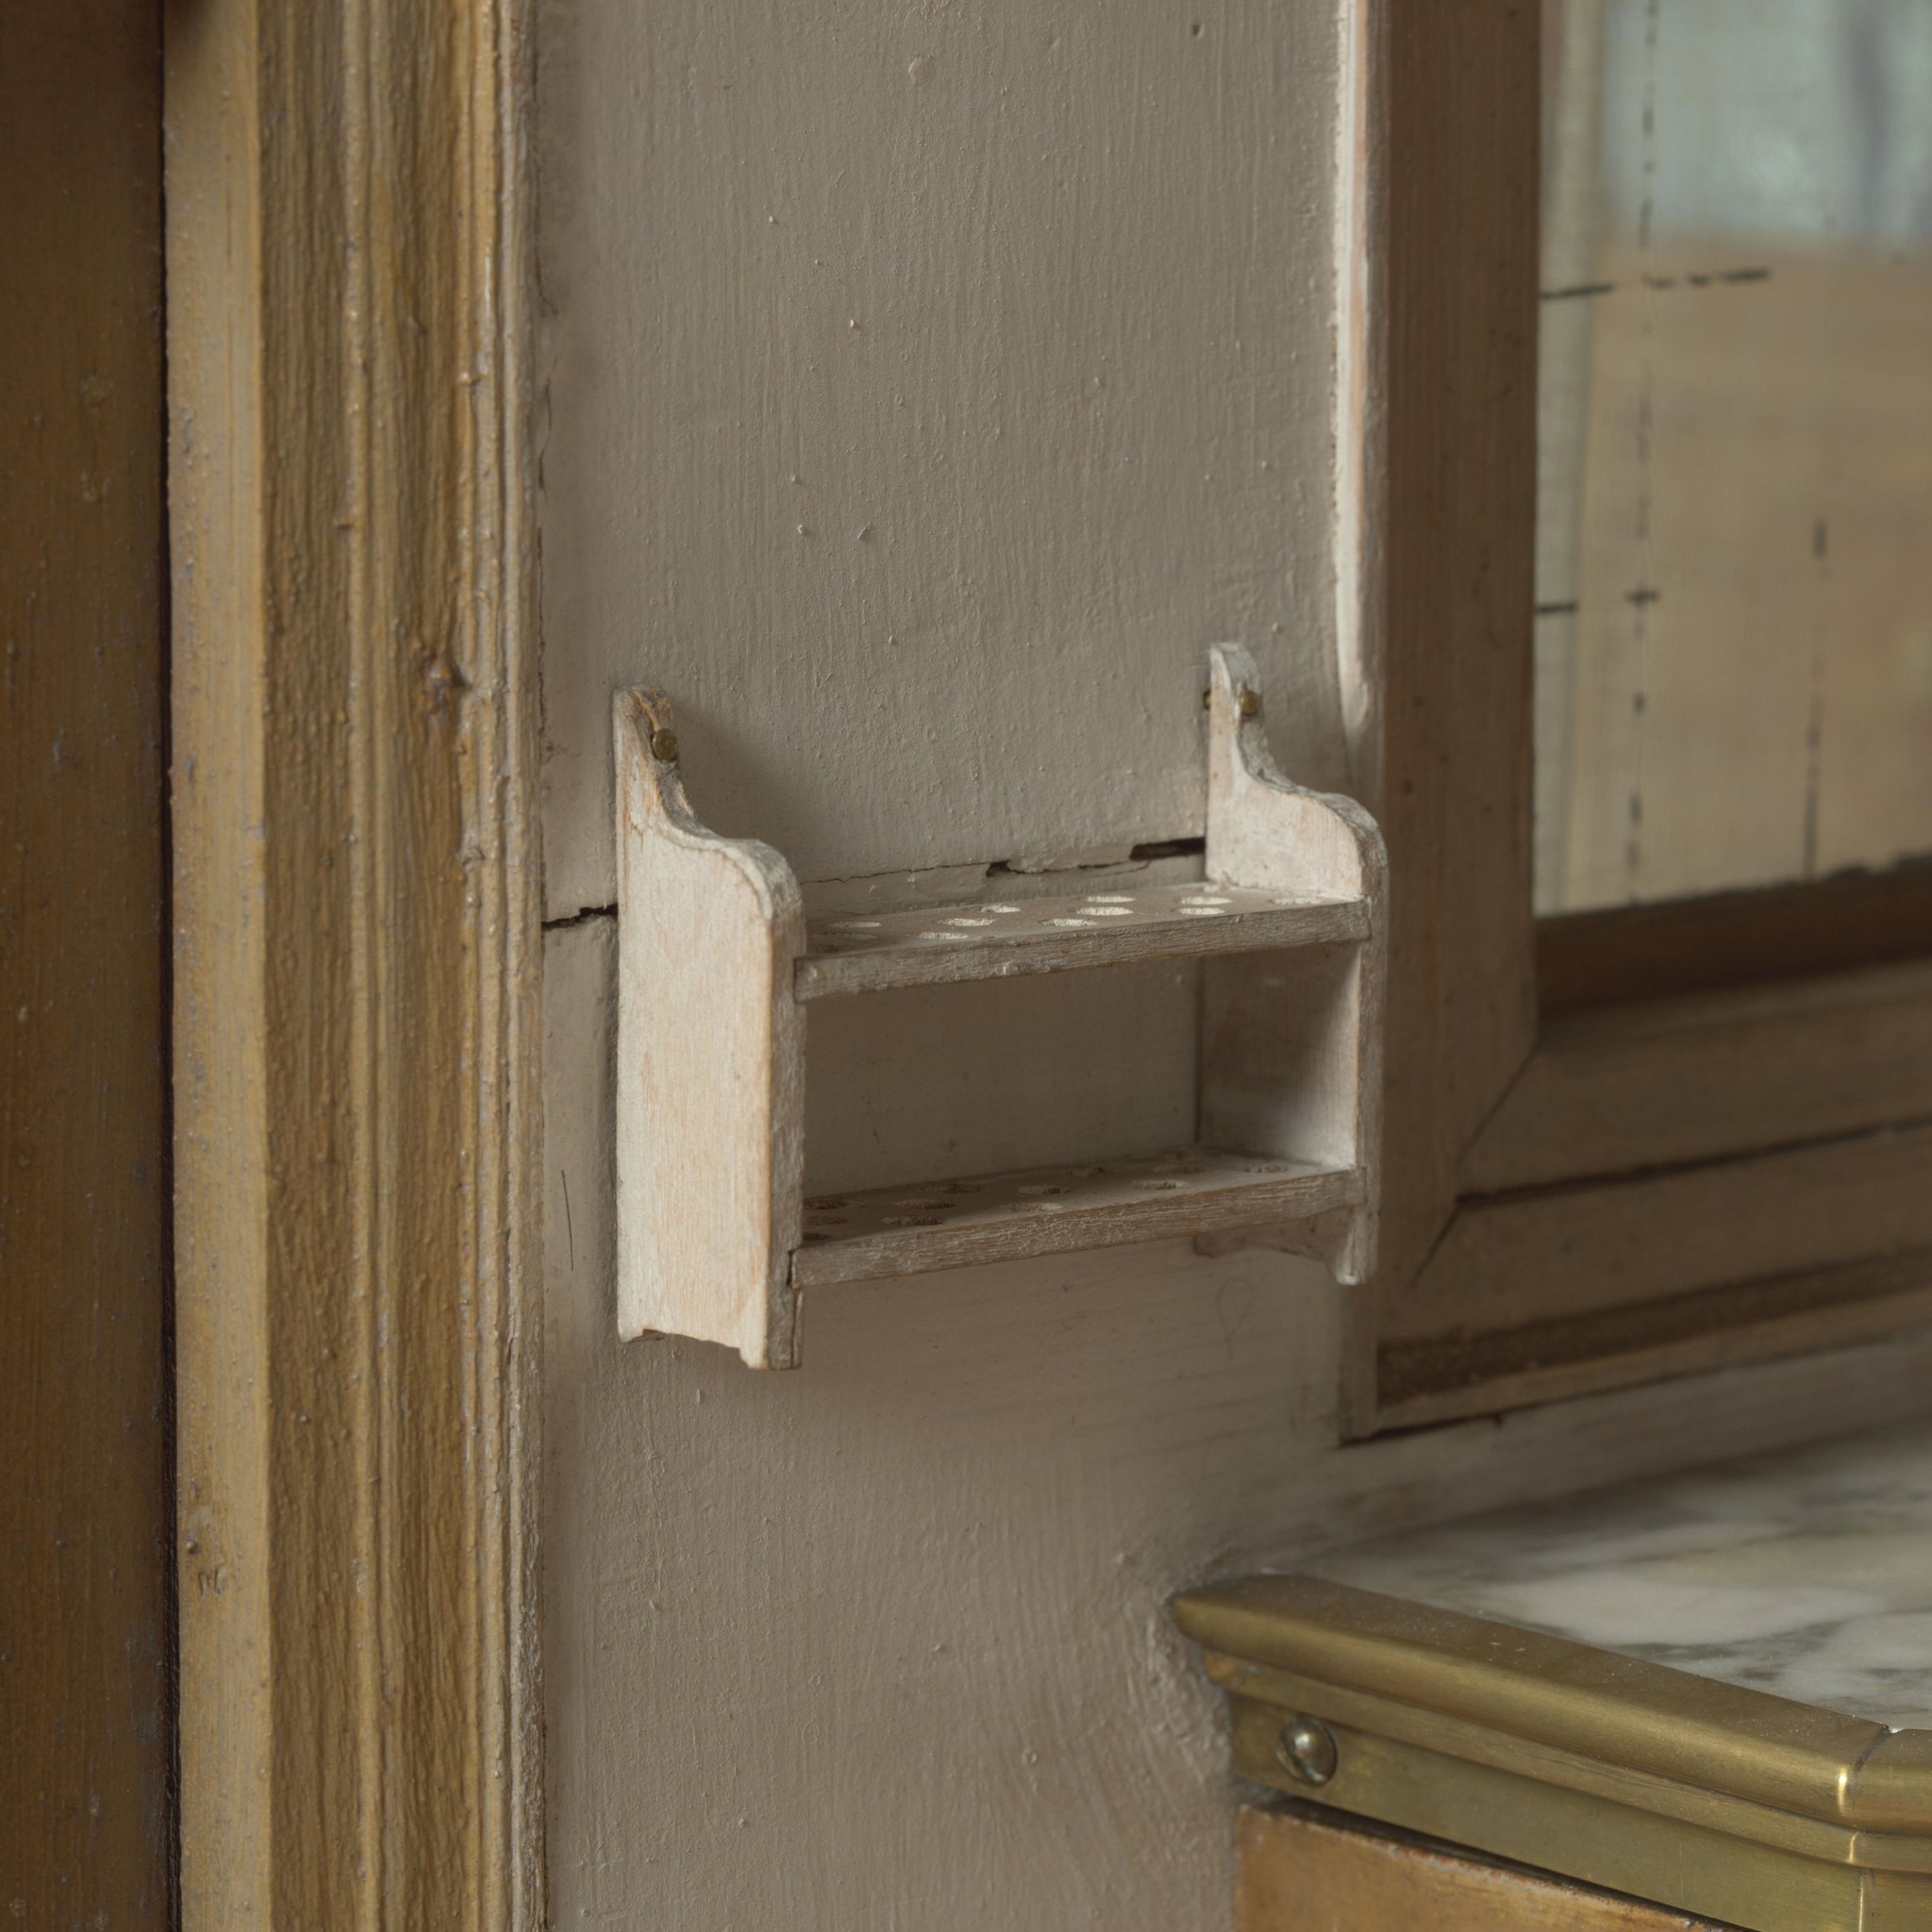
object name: rack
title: Eierrek van wit gesausde withoutsoort, met twee lagen voor totaal 28 eieren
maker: Anonymous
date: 1690-1710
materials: wood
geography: amsterdam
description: Eierek van wit gesausde withoutsoort, met twee lagen voor totaal 28 eieren.